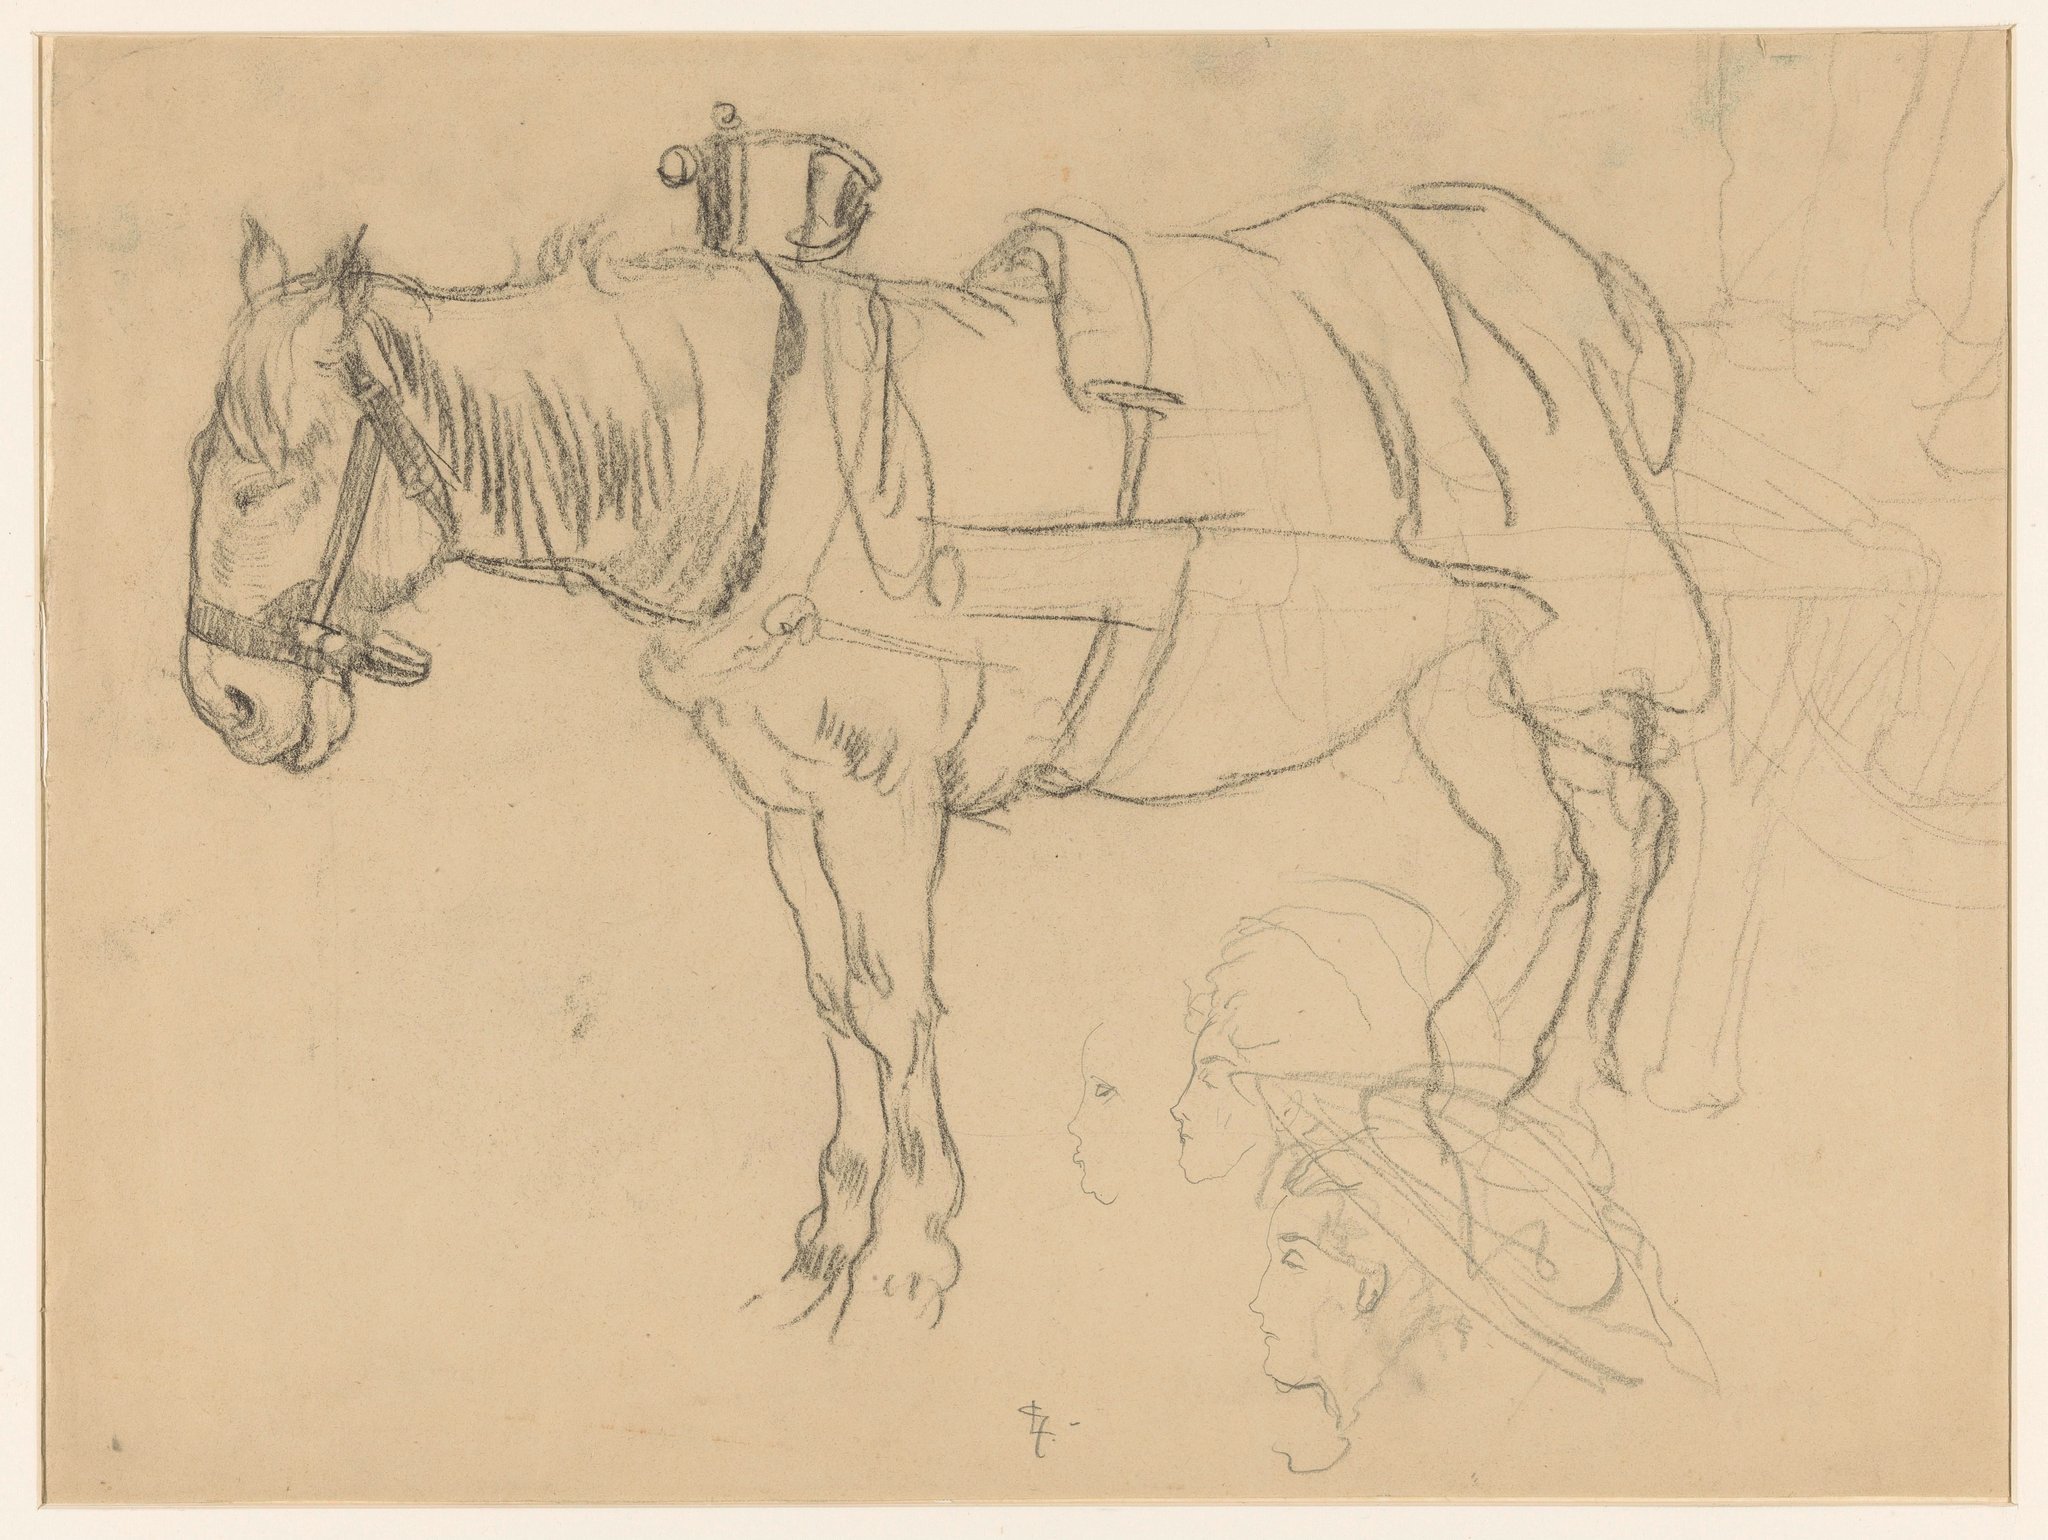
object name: drawing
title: Aangespannen paard en kopstudies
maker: leo gestel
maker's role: draughtsman, print maker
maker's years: 1881-1941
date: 1891-1941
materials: chalk, paper, pencil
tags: face, horse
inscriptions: collector's mark: Lugt 2760, collector's mark: Lugt 2228